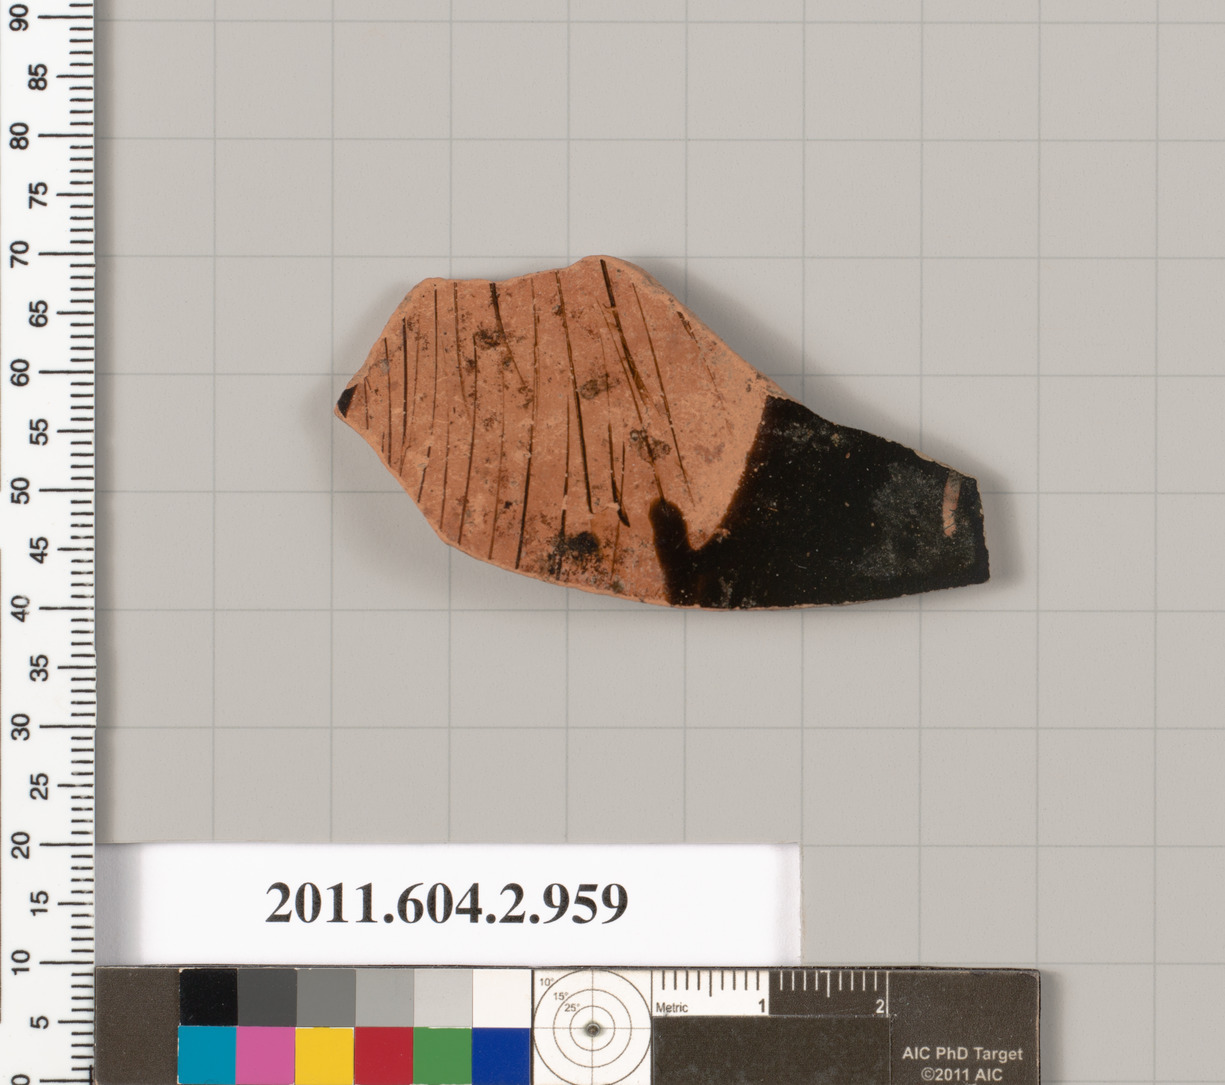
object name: oinochoe fragment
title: Terracotta fragment of an oinochoe (jug)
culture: greek, attic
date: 460-450 BCE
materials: terracotta